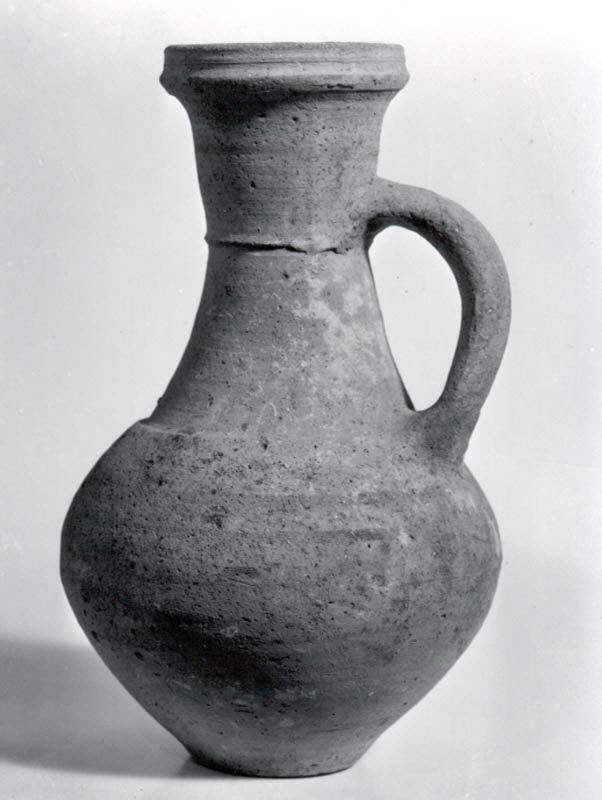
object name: jug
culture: israelite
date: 734-601 BCE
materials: ceramic, paint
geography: levant